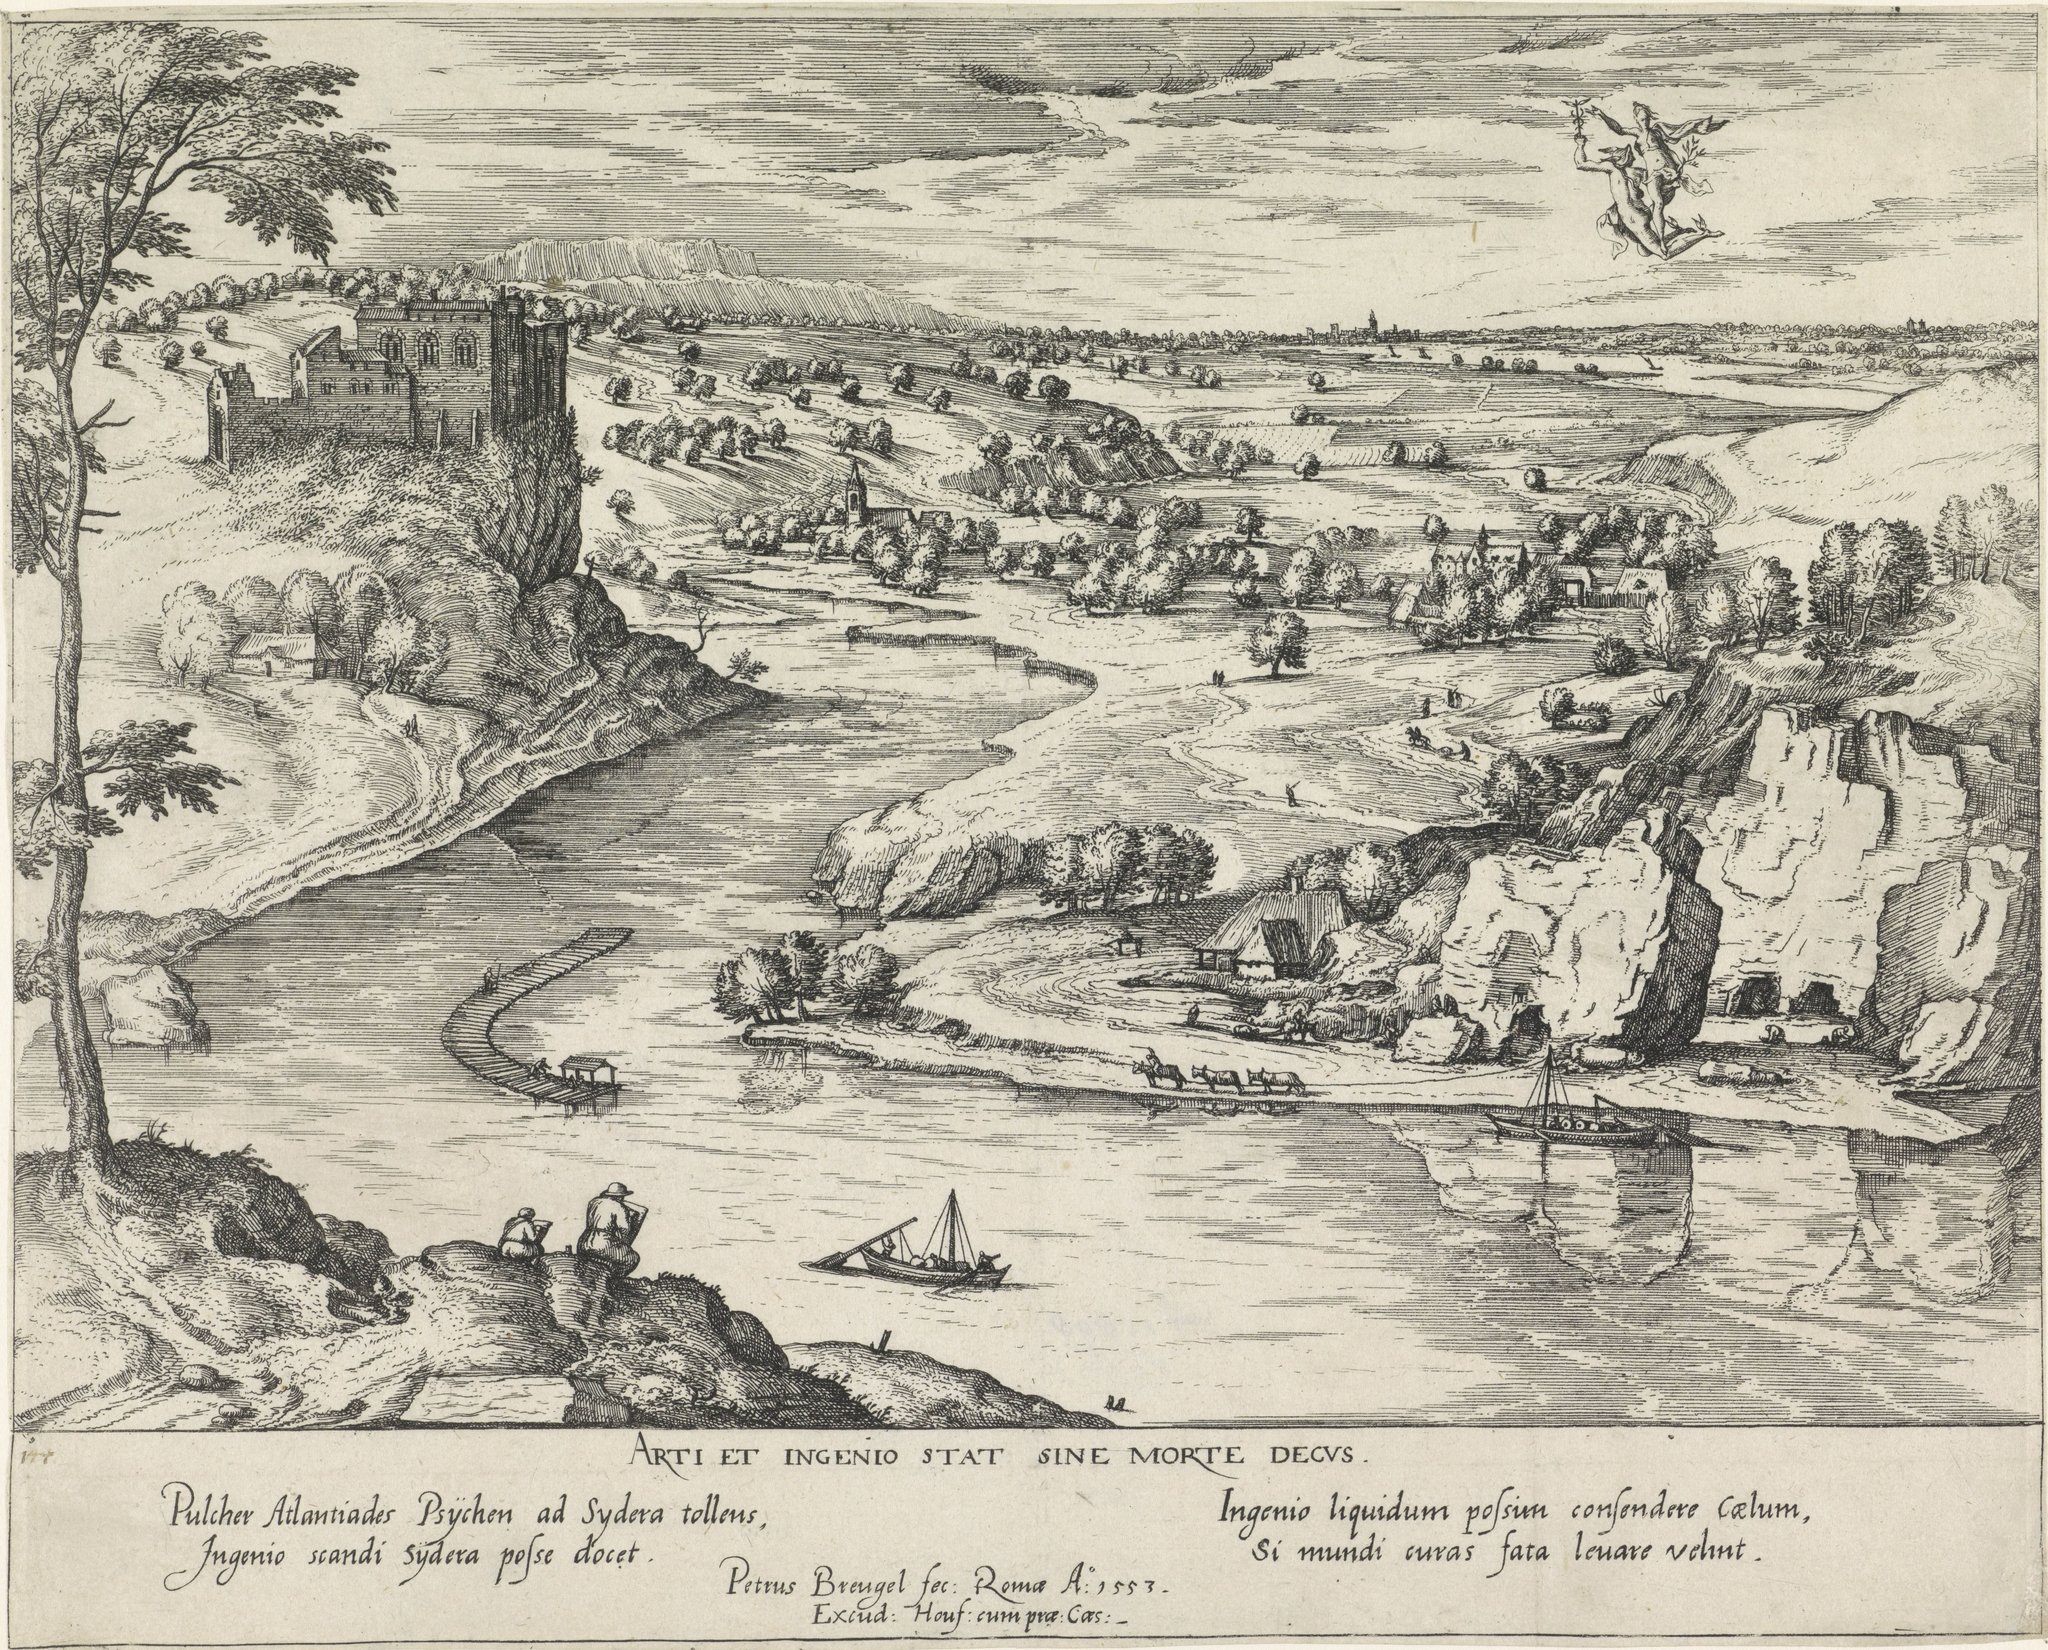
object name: print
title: Rivierlandschappen met mythologische onderwerpen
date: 1553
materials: paper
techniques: etching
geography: vienna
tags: psyche is carried up to olympus by mercury, landscapes in the temperate zone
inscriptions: signature: ‘PerusBreugel fec.’, date: ‘Ao 1553’, caption: ‘Pulcher Atlantiades Psijchen ad Sydera tollens...Si mundi curas fata levare velint.’, collector's mark: Lugt 2228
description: Rivierlandschap met in de lucht Mercurius, die Psyche naar de hemel draagt.